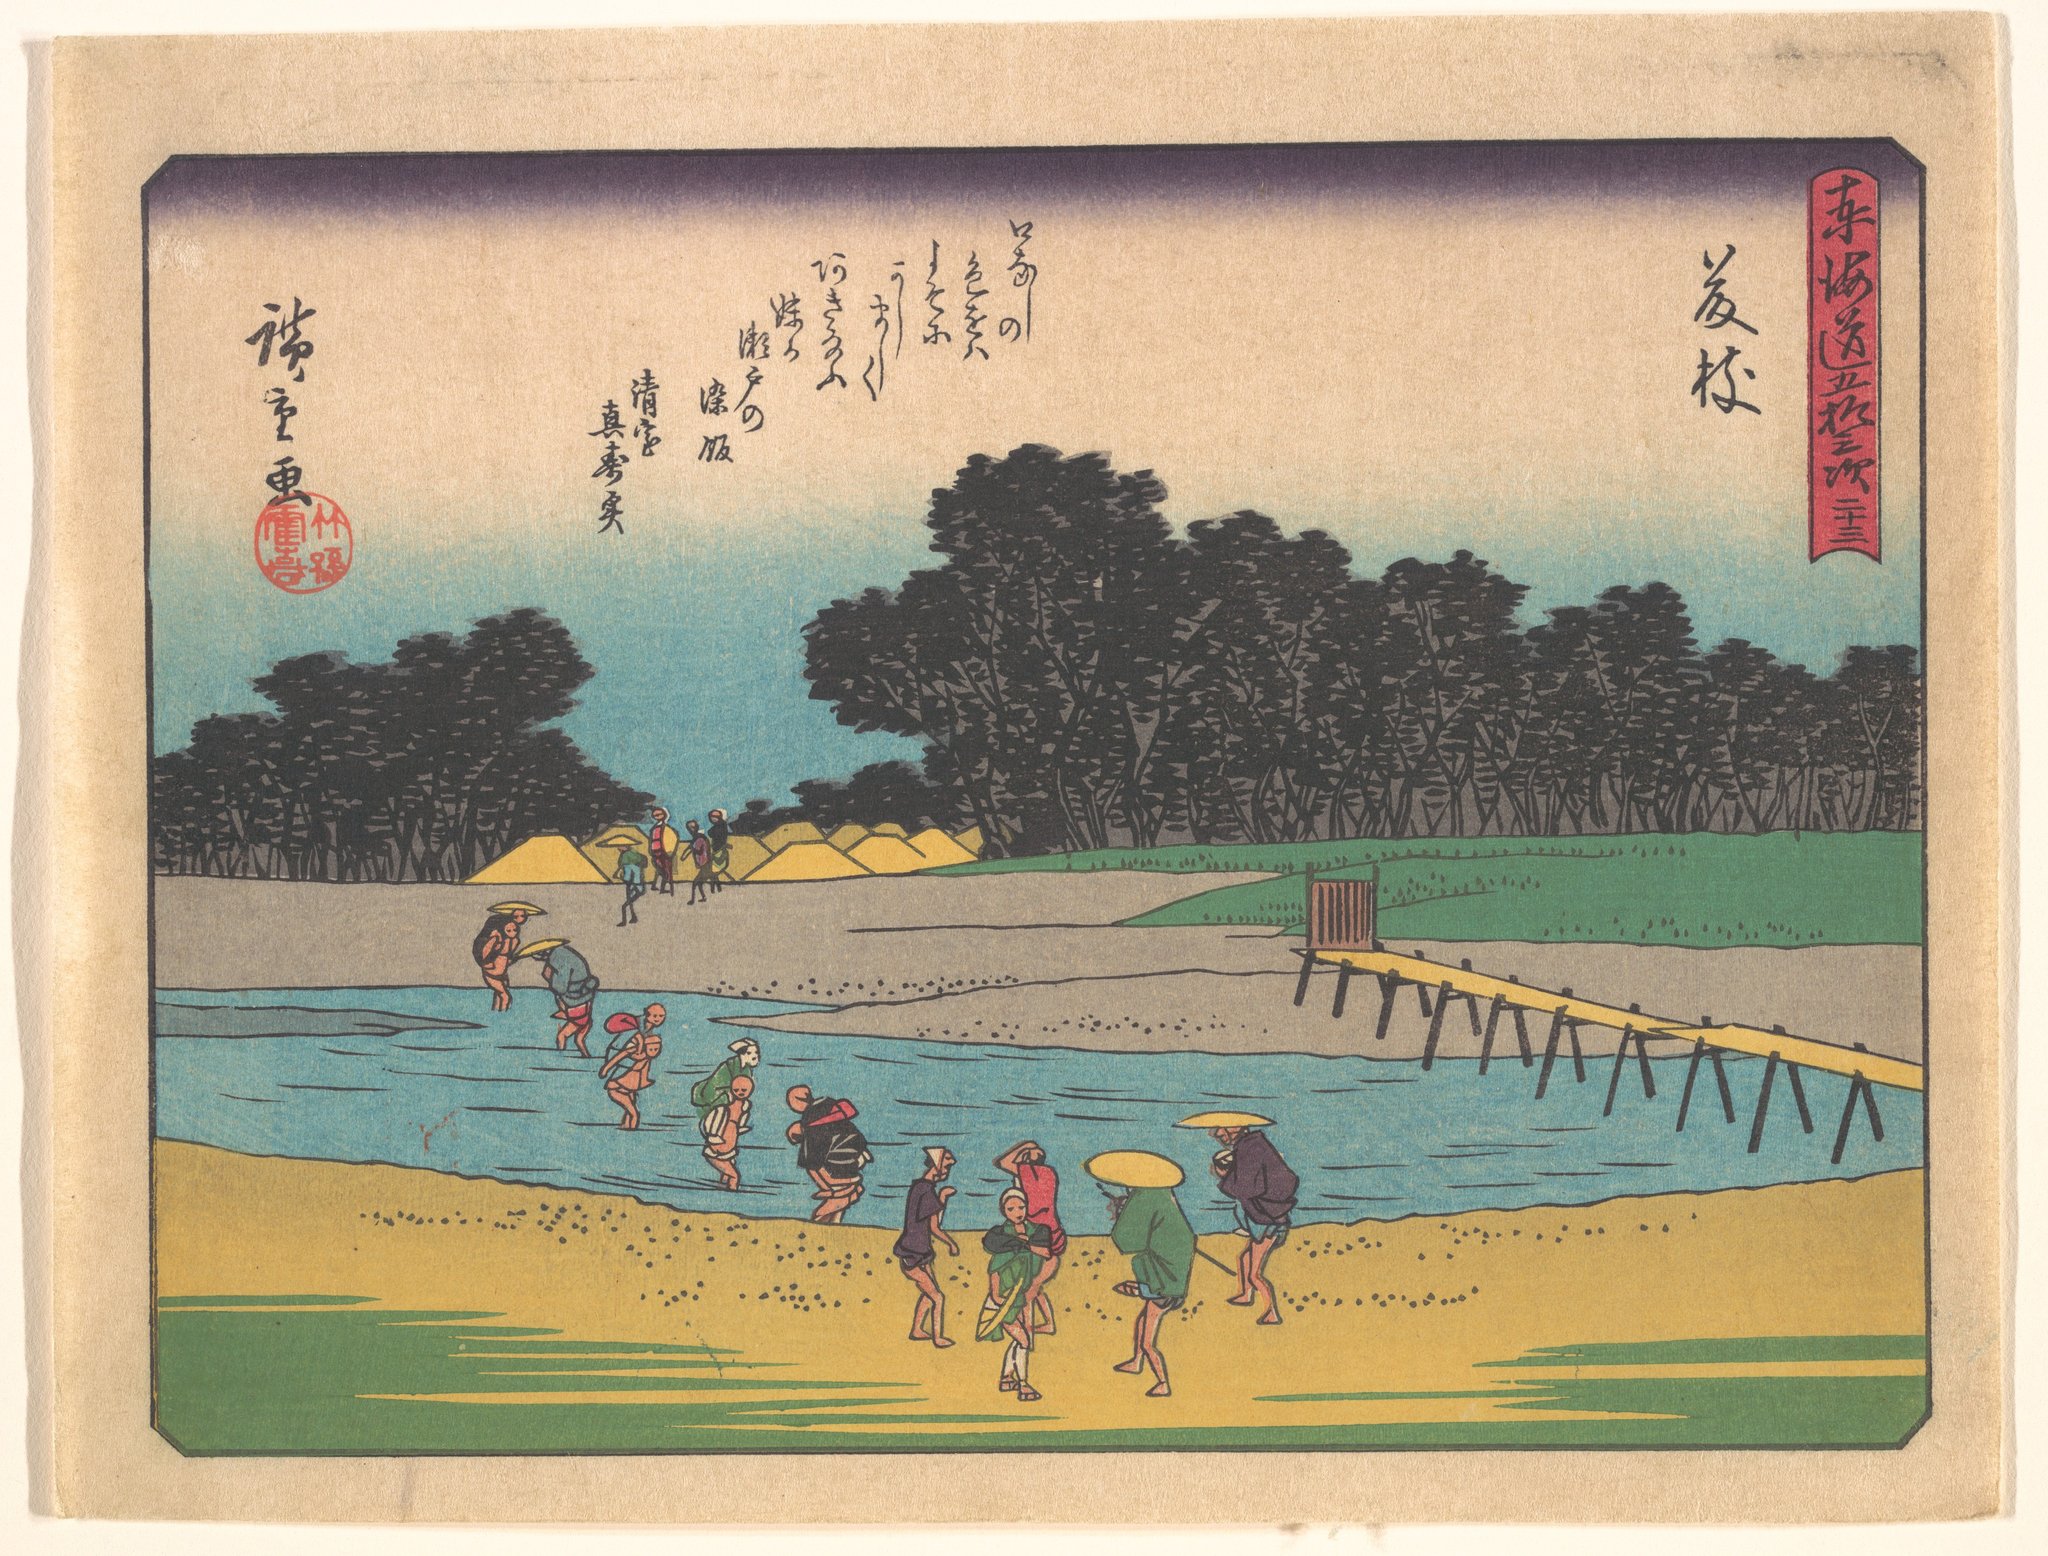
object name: print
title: 東海道五十三次 藤枝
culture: japanese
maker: utagawa hiroshige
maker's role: artist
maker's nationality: japanese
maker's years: 1797-1858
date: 1901-1933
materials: ink, paper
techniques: woodblock print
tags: human figures,bridges,trees,streams